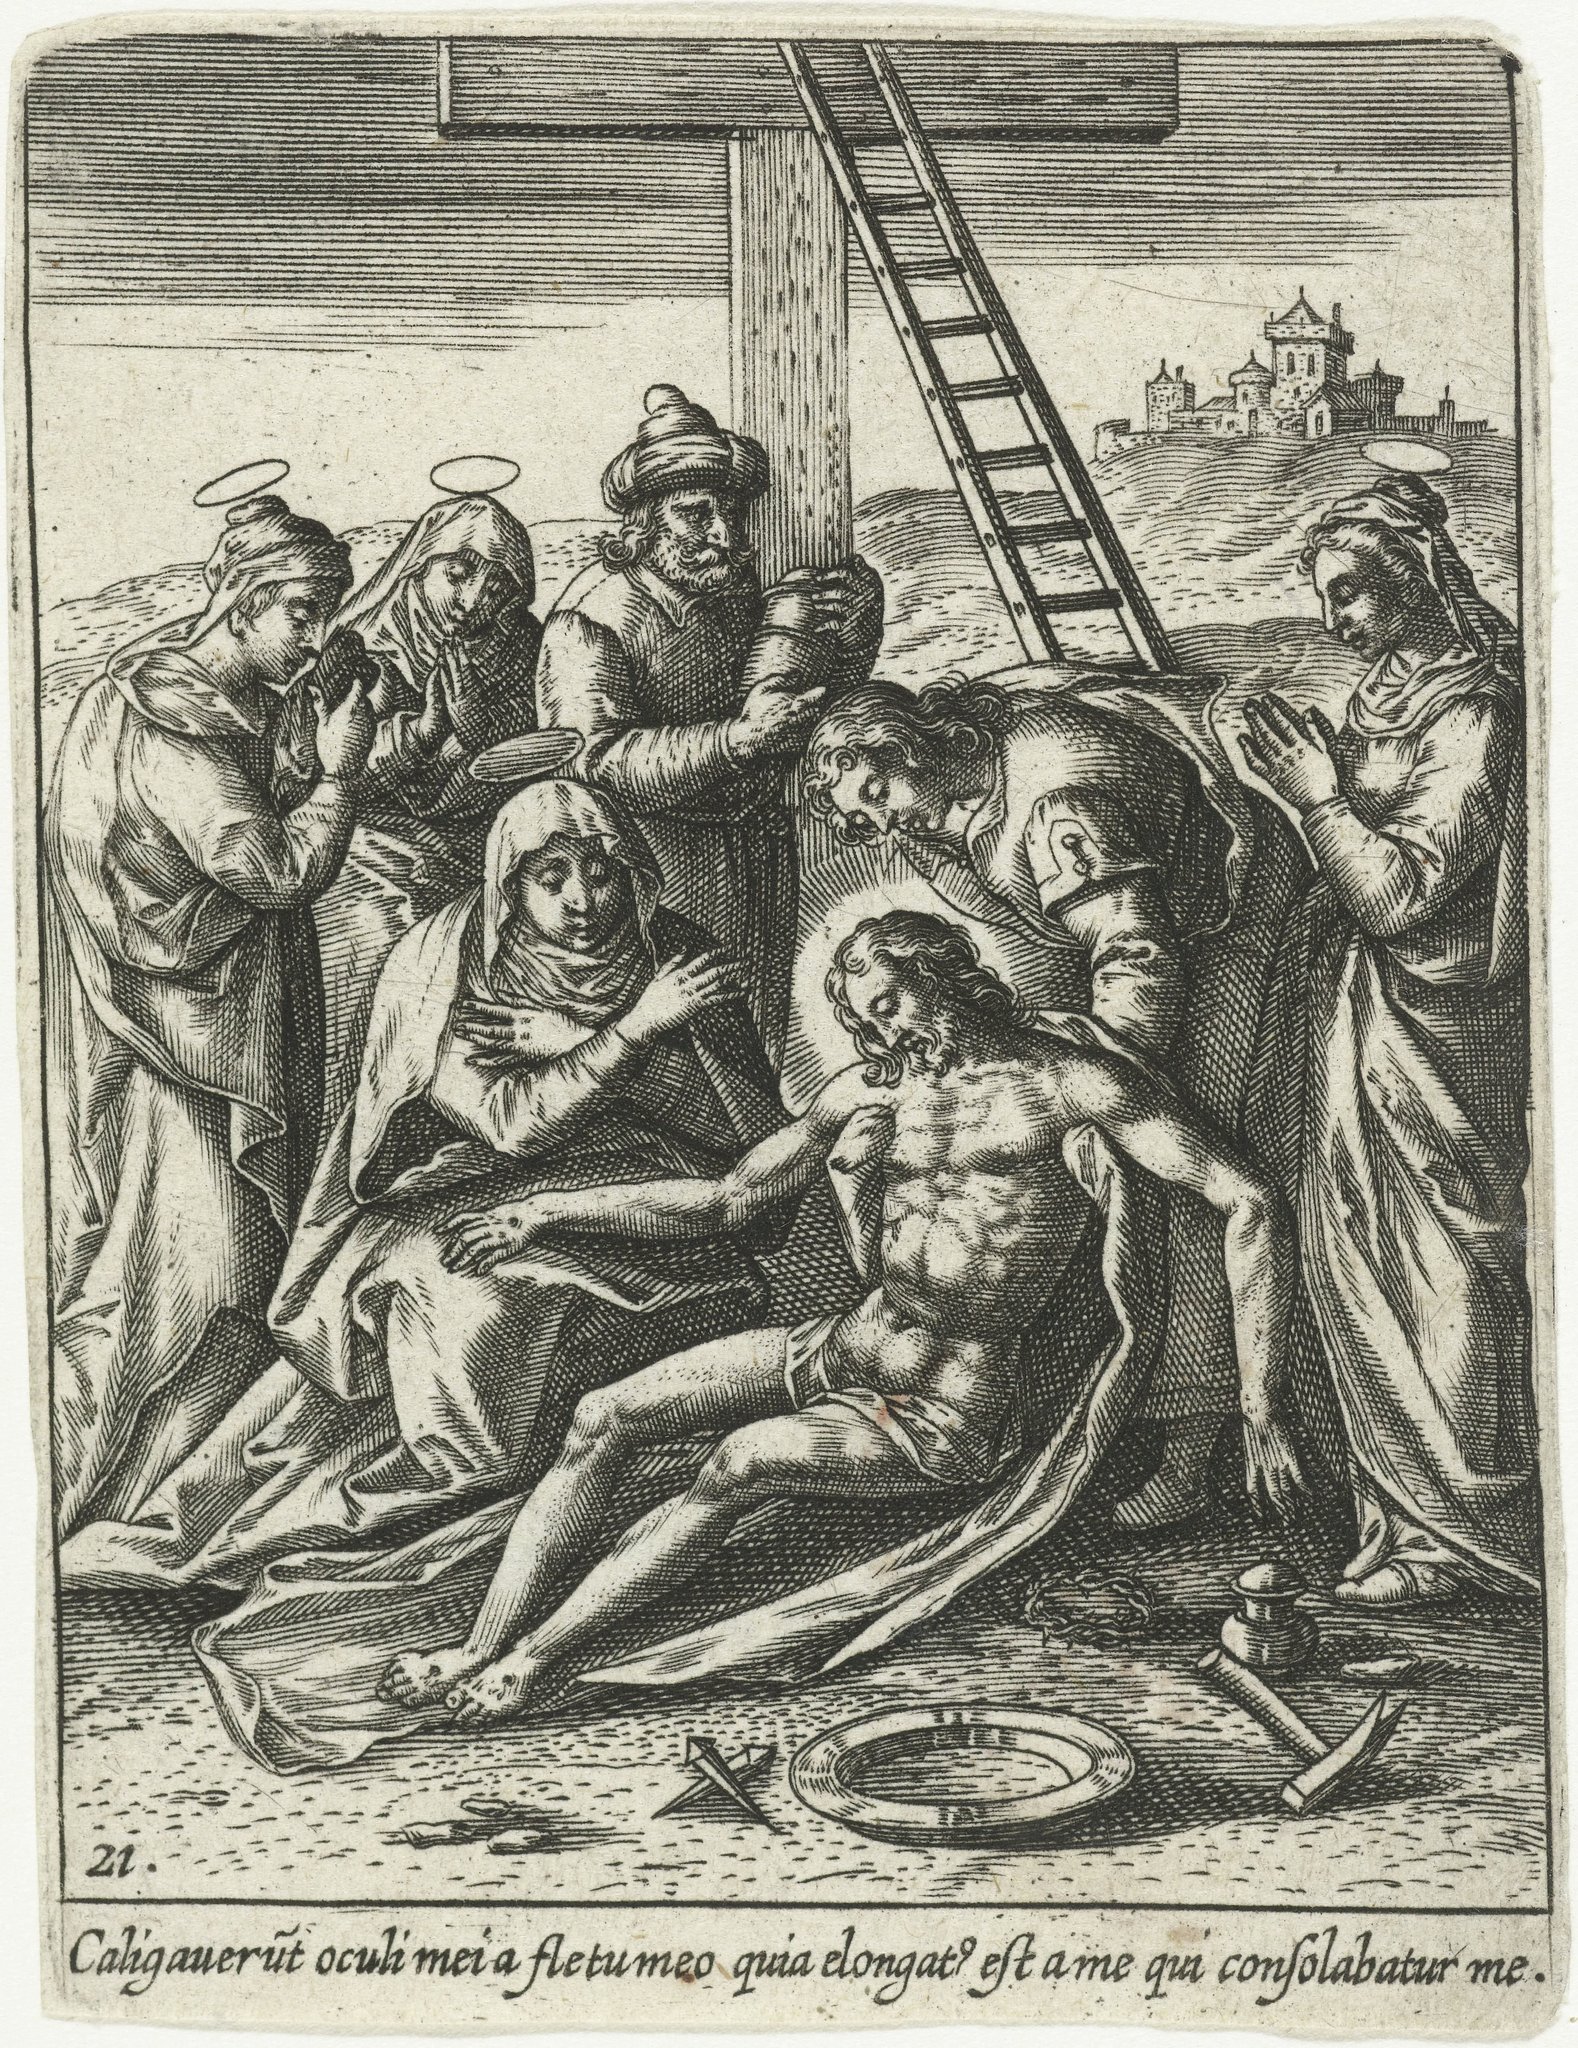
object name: print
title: Passie en wederopstanding van Christus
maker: adriaen collaert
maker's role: draughtsman, print maker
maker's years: 1560-1618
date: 1570-1618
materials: paper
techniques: engraving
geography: antwerp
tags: lamentation over the dead christ by his relatives and friends (christ usually without crown of thorns)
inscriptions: collector's mark: Lugt 240, collector's mark: Lugt 2228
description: Christus wordt op de grond gelegd nadat de spijkers uit zijn handen zijn gehaald. Iedereen rouwt. De prent heeft een Latijns onderschrift